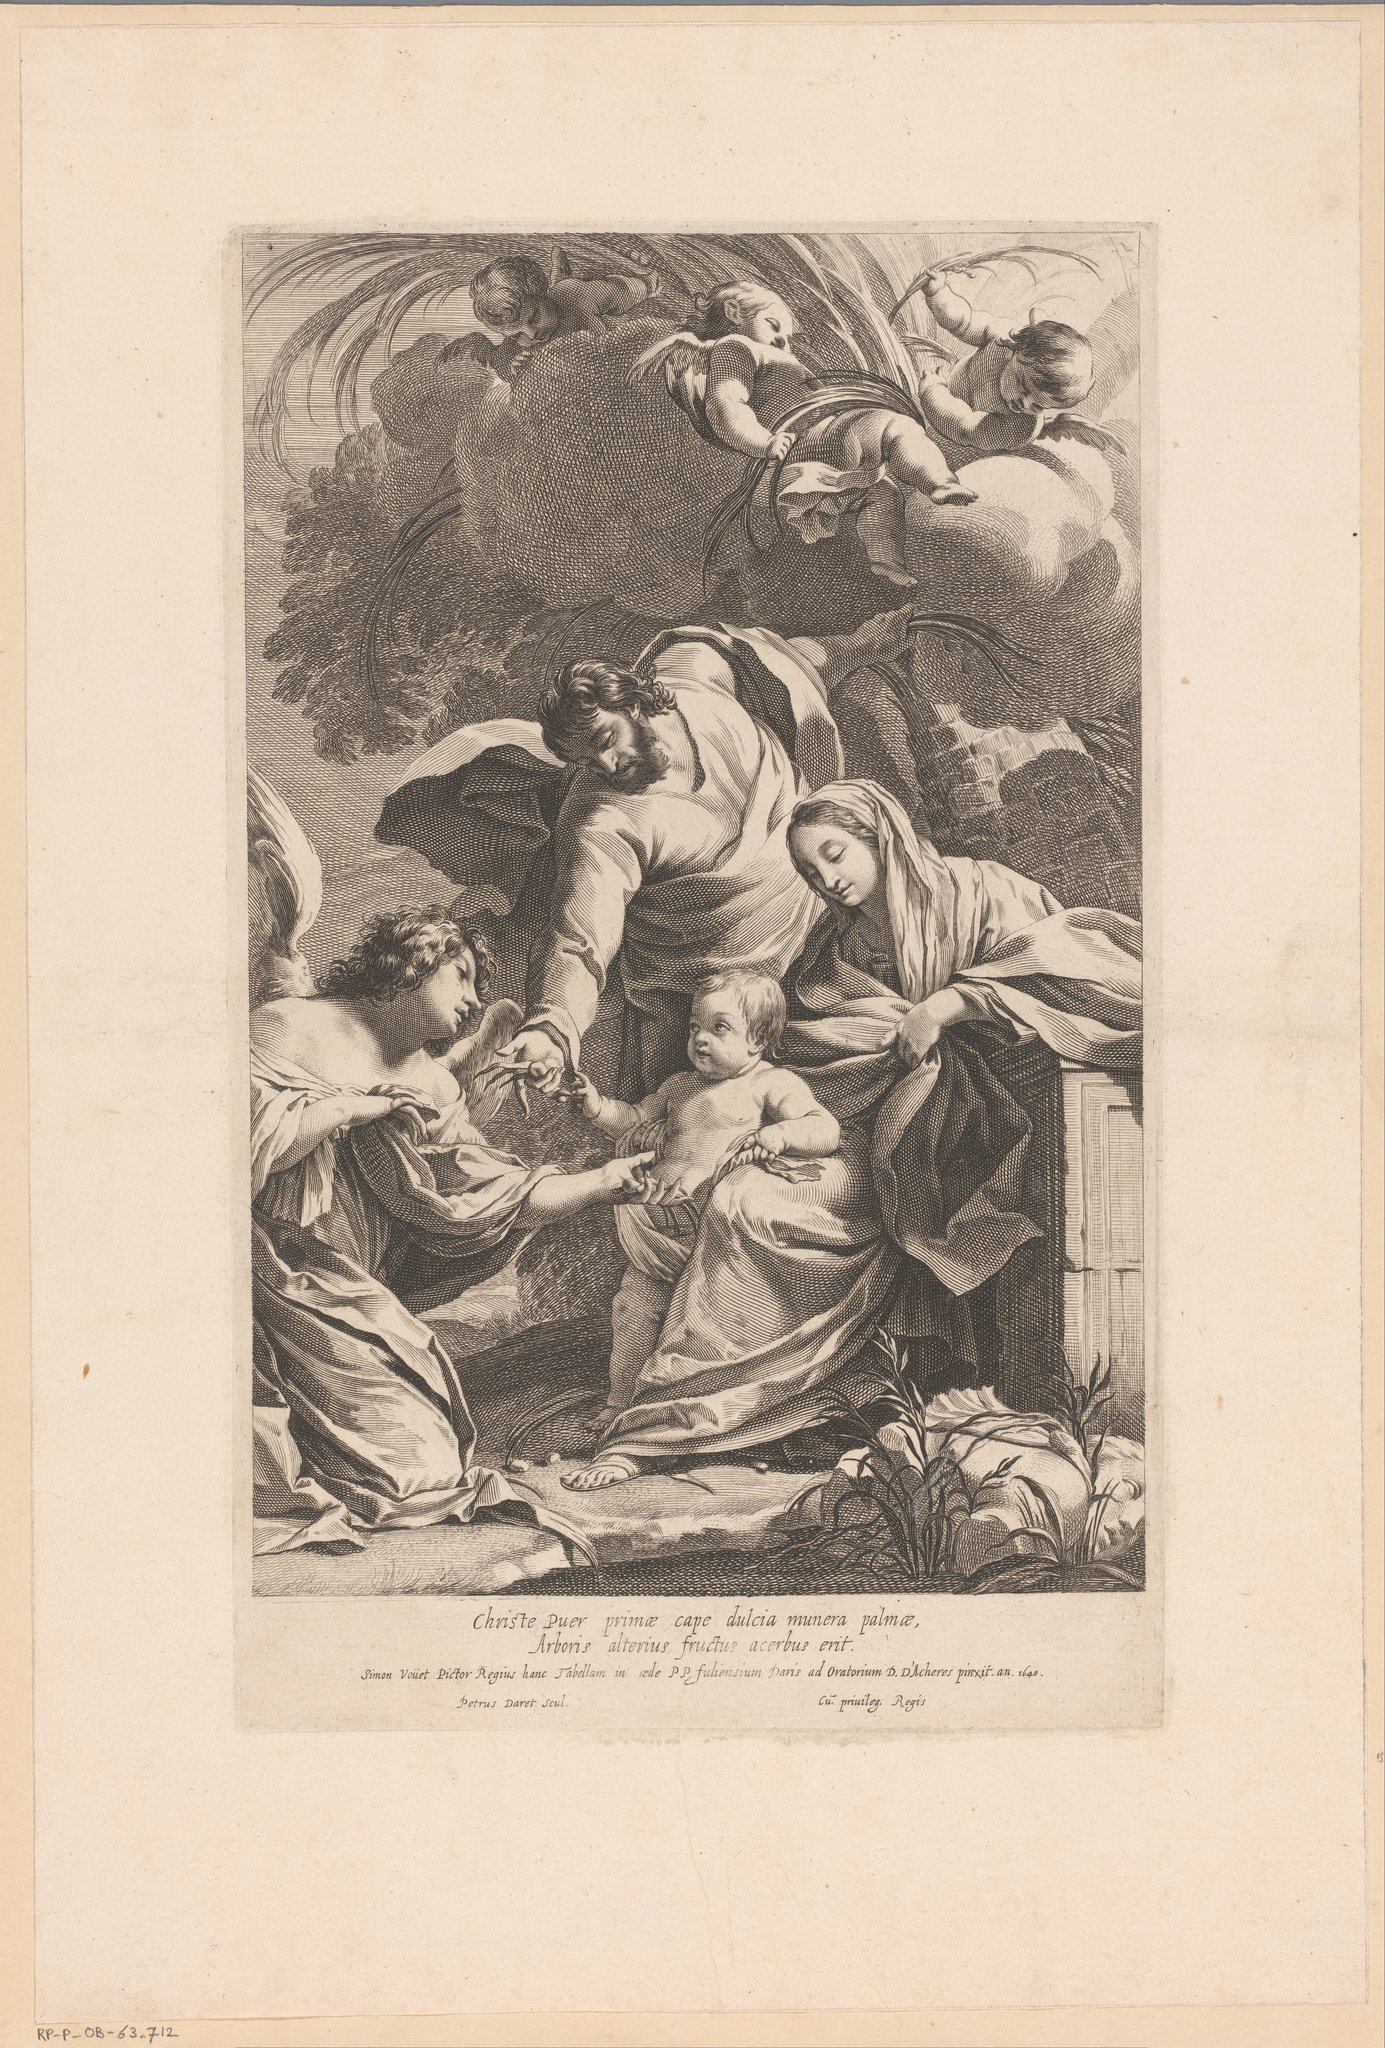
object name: print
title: Heilige Familie met engelen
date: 1640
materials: paper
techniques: engraving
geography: paris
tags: holy family, and derived representations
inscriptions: collector's mark: Lugt 240